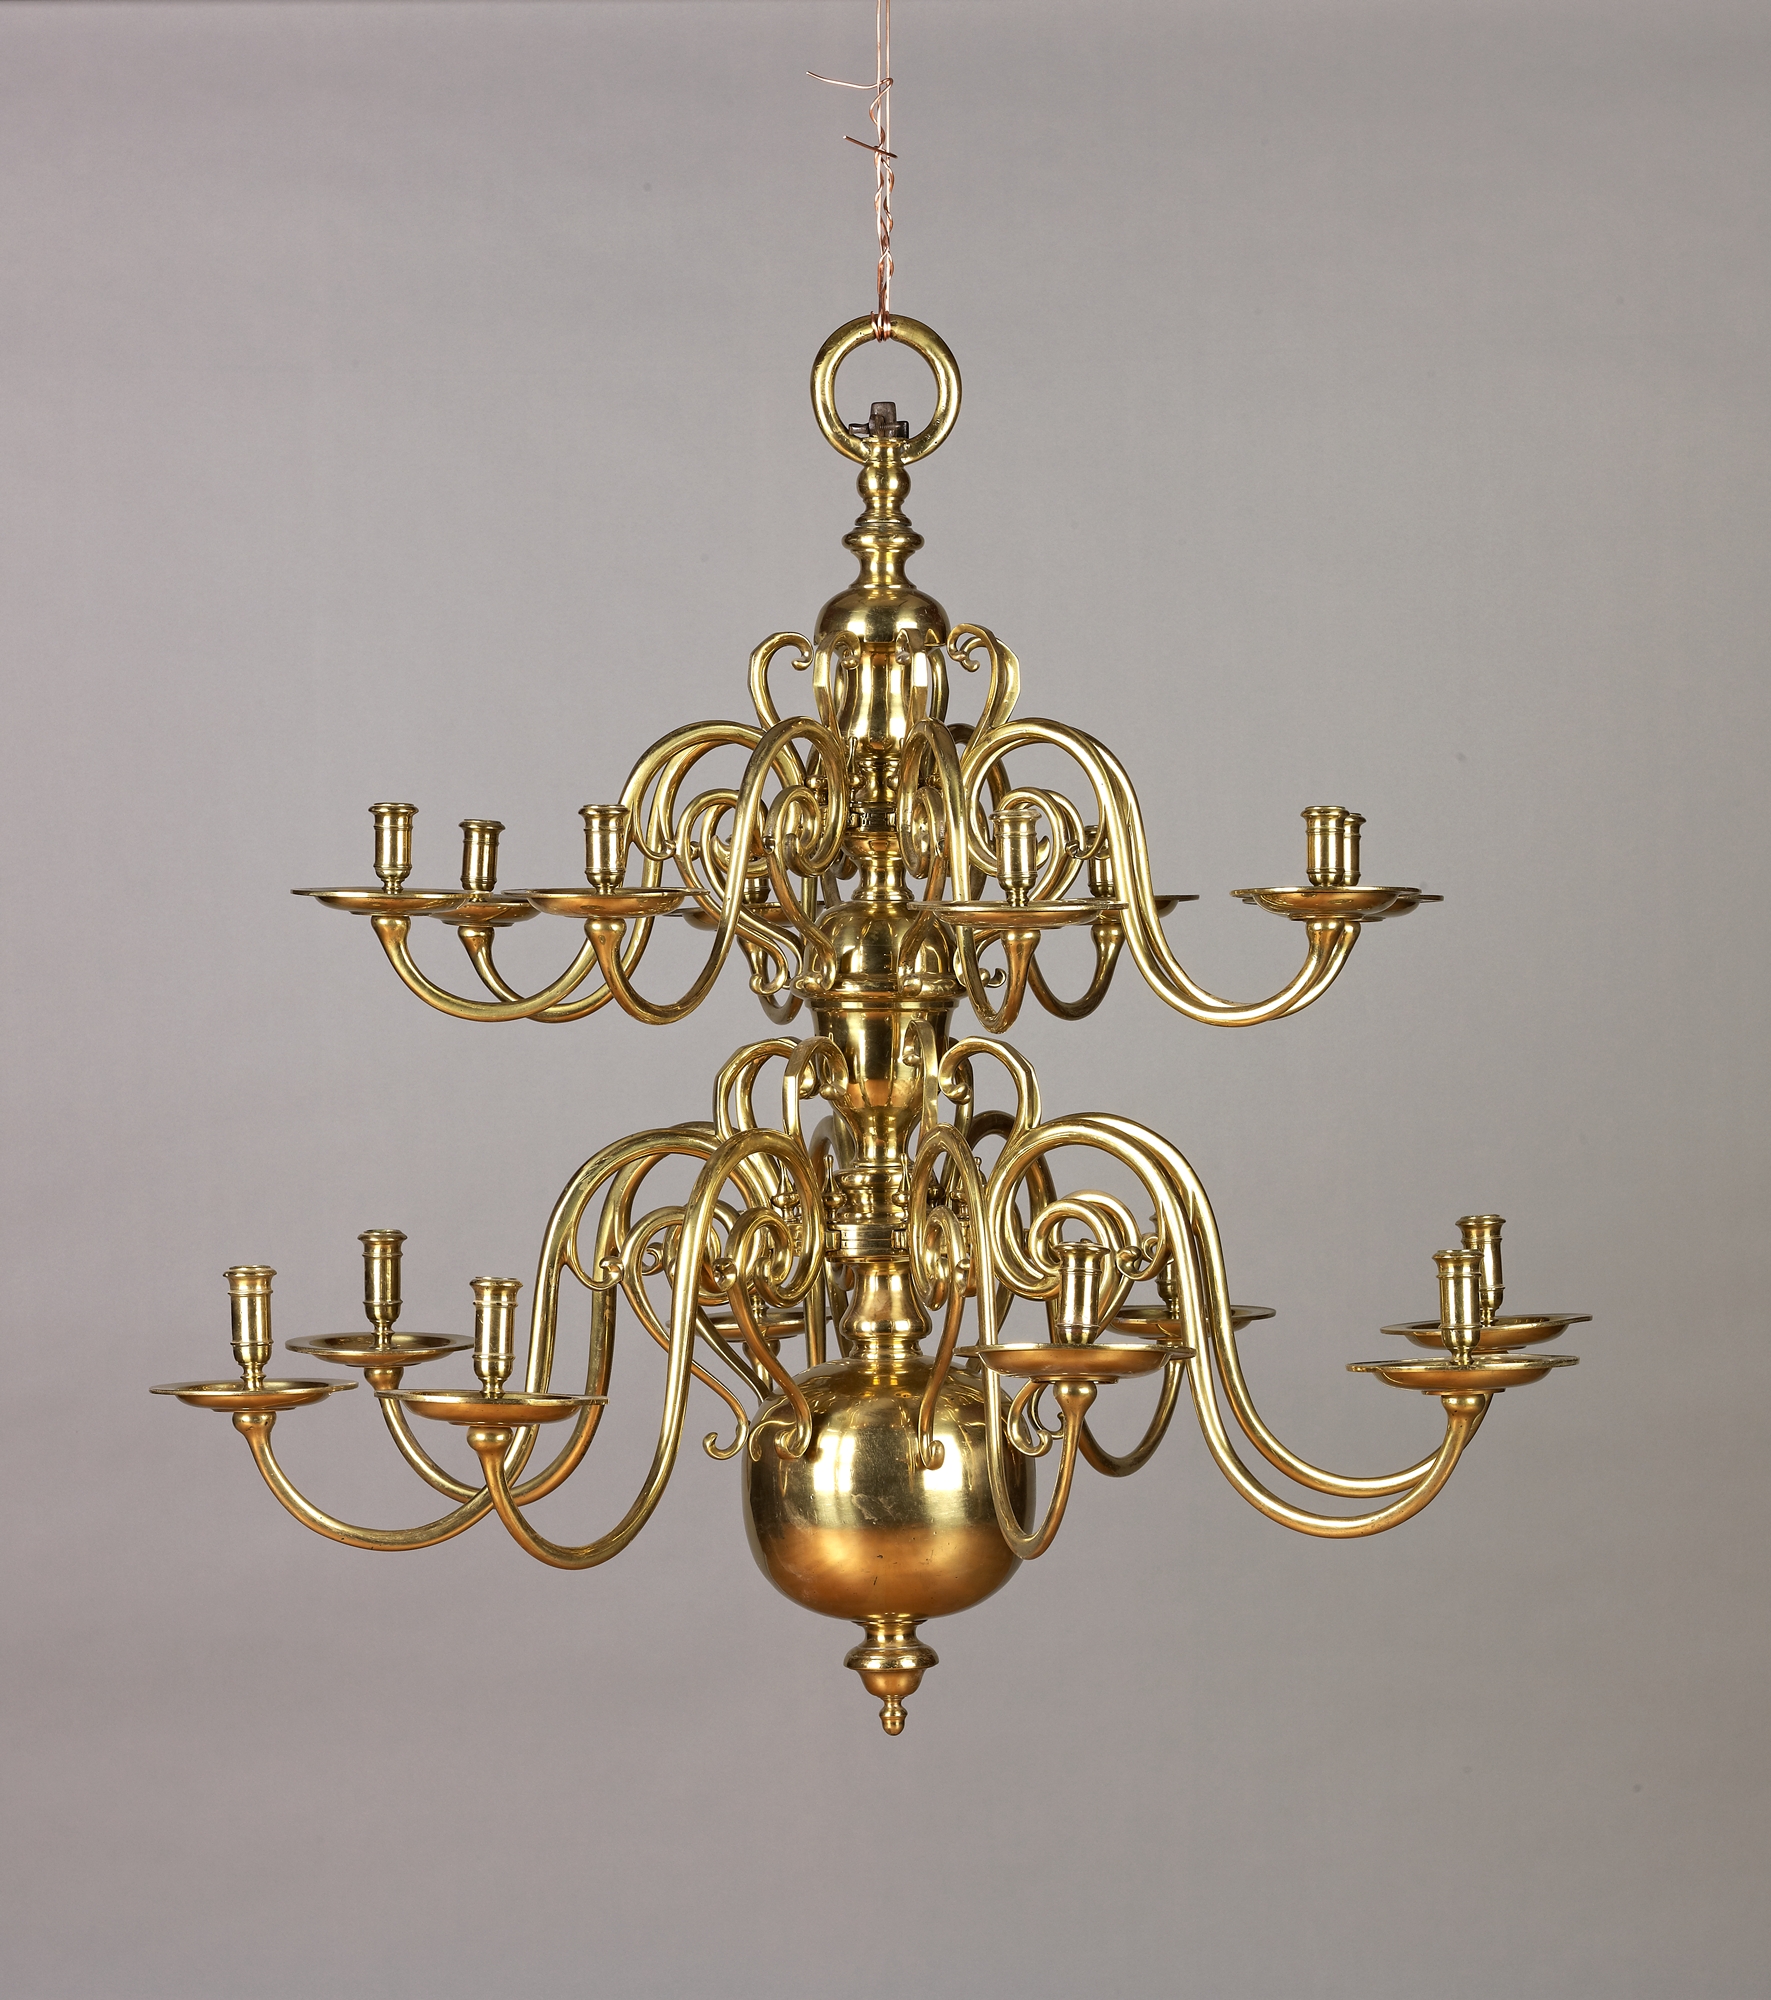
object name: chandelier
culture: dutch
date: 1701-1800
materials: brass